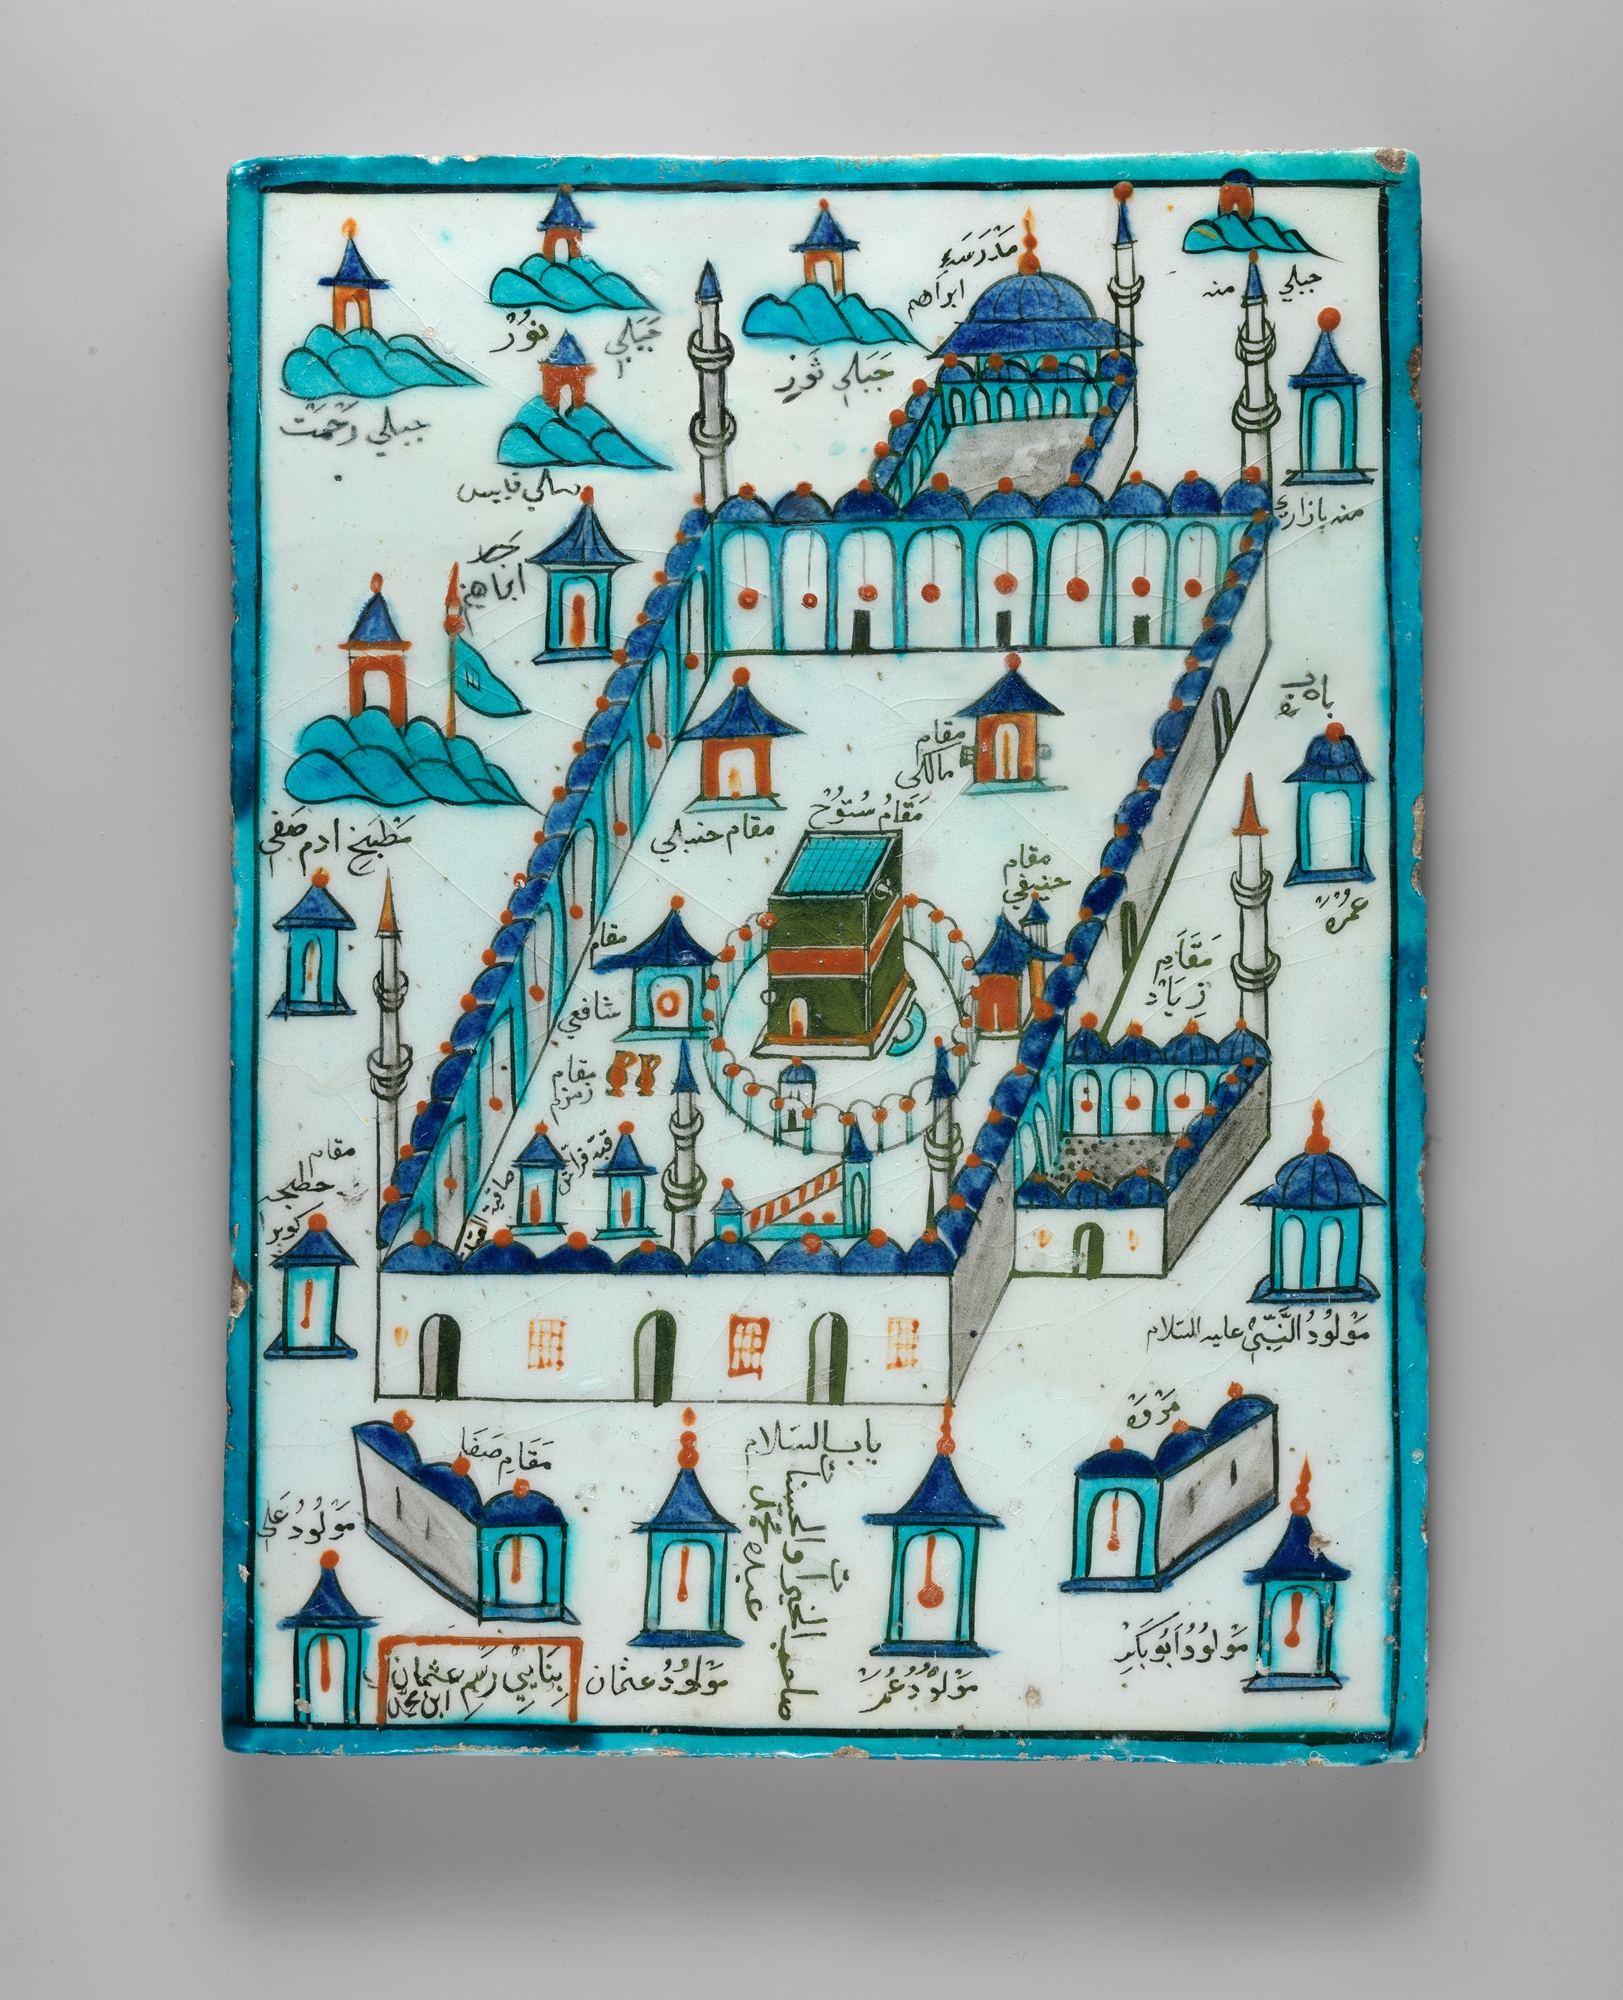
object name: tile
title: Ka'ba Tile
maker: osman ibn mehmed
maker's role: artist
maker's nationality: turkish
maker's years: 18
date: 1720-1730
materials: glaze, stonepaste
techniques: painting, polychrome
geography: turkey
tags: buildings